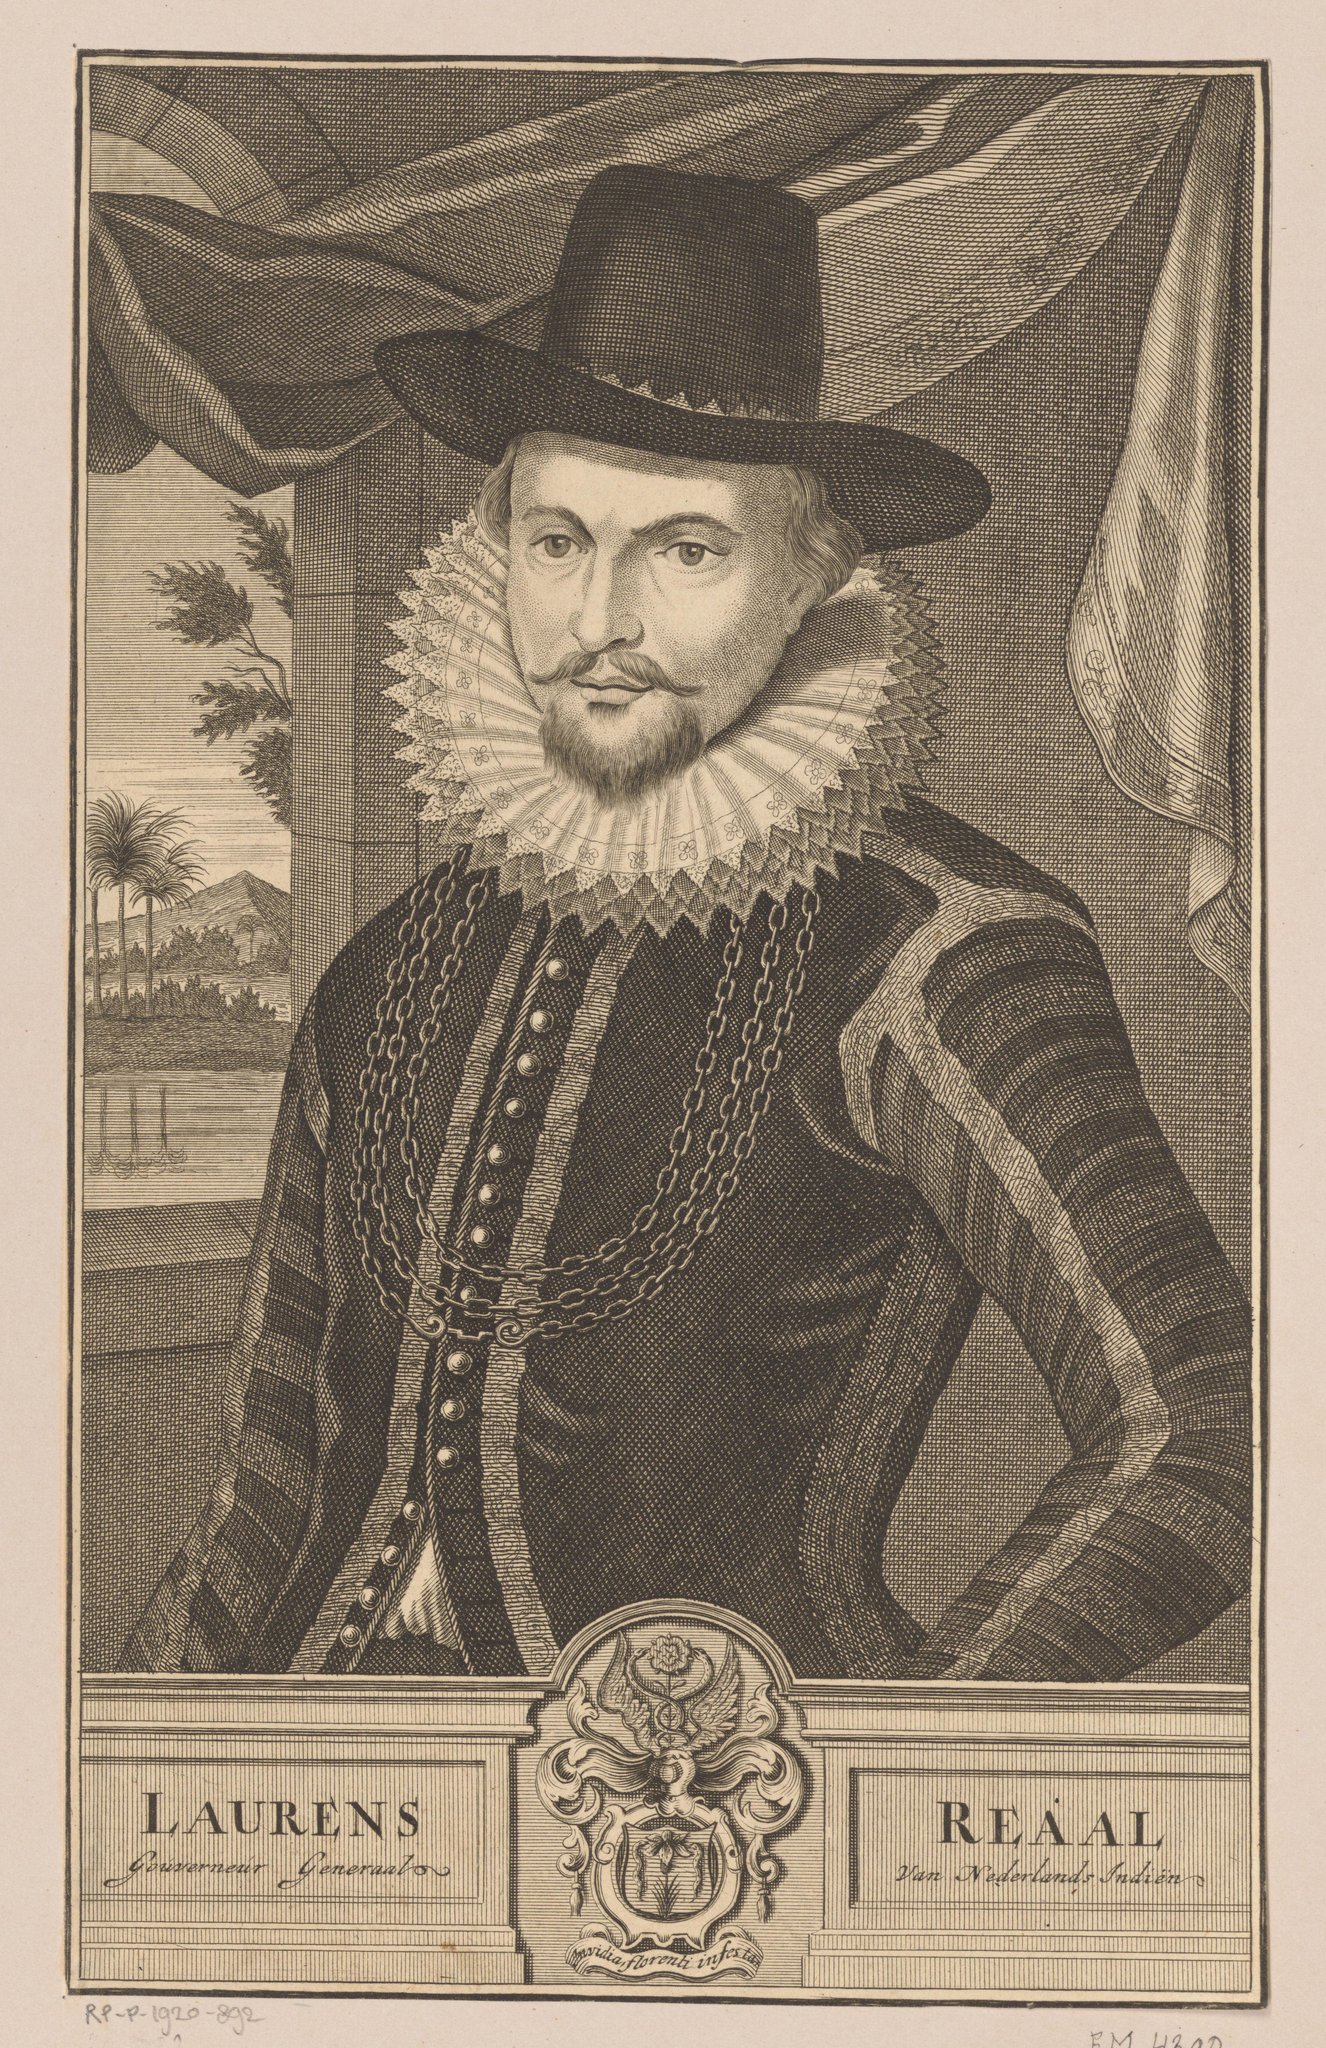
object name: print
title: Portret van Laurens Reael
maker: dirk jongman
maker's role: print maker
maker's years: 1684-1726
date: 1724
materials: paper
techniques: engraving, etching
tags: laurens reael, historical persons, trees: palm-tree, armorial bearing, heraldry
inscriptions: collector's mark: Lugt 2228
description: Prent mogelijk uit: Valentyn, François. Oud en nieuw Oost-Indiën, vervattende een naaukeurige en uitvoerige verhandelinge van Nederlands mogentheyd in die gewesten. Dordrecht en Amsterdam: Joannes van Braam en Gerard onder de Linden, 1724, dl. 4.